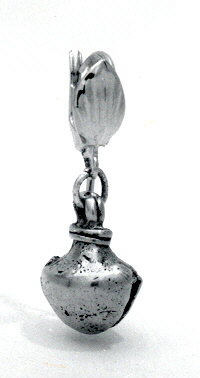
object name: ornament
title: Pendant Bell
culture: costa rican or panamanian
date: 701-1600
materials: gold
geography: costa rica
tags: musical instruments